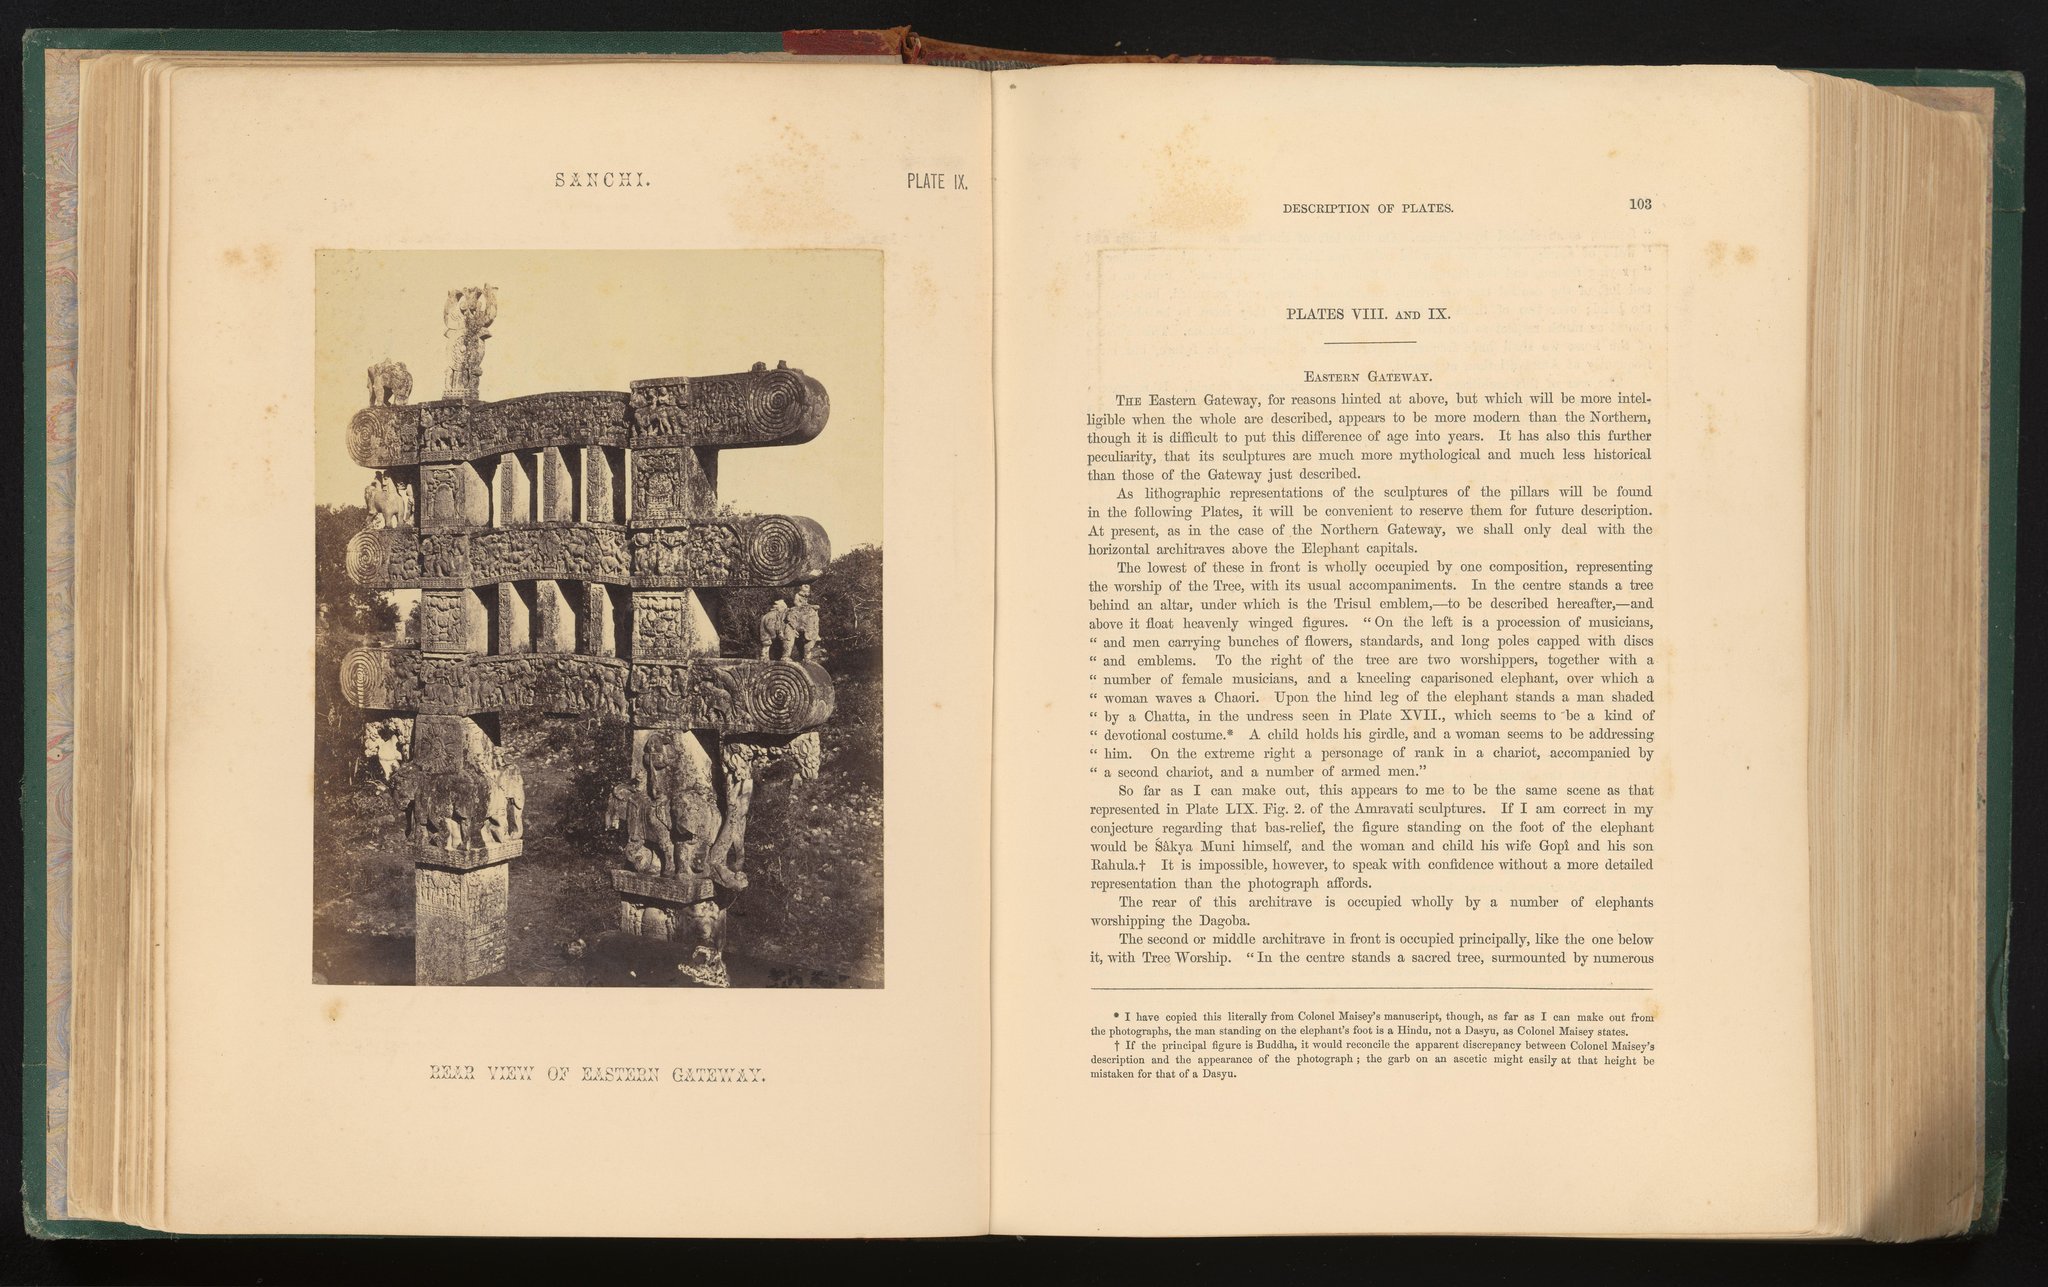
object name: photograph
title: Rear view of the eastern gateway (torana) of the Great Stupa at Sanchi, Madhya Pradesh, India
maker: james john waterhouse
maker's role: fotograaf, luitenant, officier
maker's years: 1842-1928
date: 1863-1868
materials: photographic support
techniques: albumen print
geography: sanchi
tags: places and objects of worship ~ hinduism, buddhism, jainism, gate, entrance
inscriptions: inscription: ‘SANCHI. PLATE IX./ REAR VIEW OF EASTERN GATEWAY.’